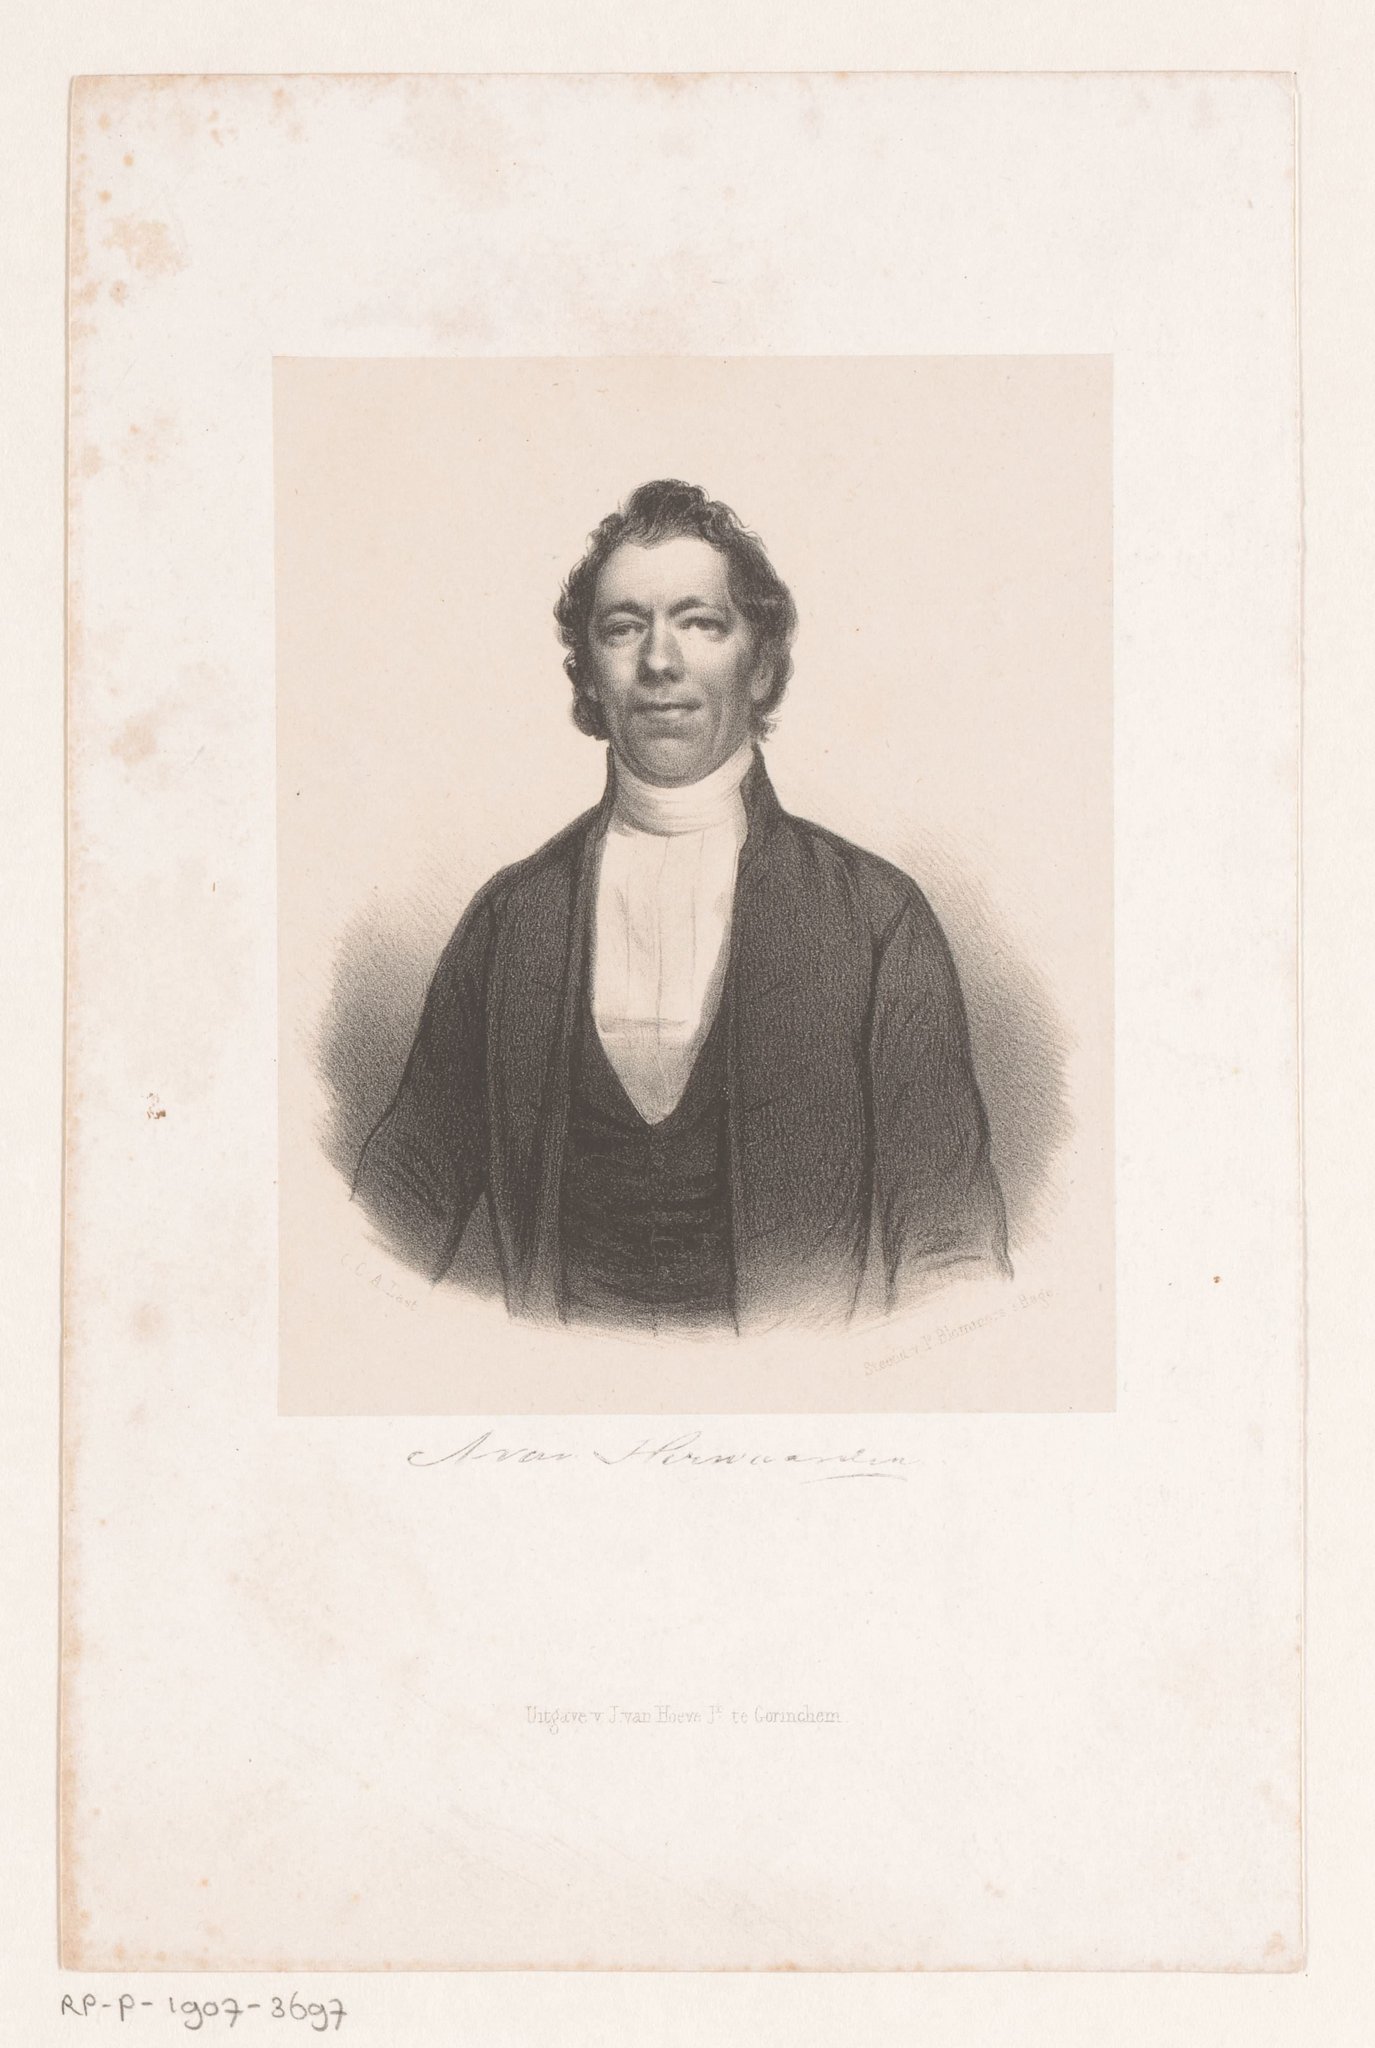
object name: print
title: Portret van Adrianus van Herwaarden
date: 1842-1887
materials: paper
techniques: lithograph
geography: netherlands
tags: historical persons (+ (full) bust portrait)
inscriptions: collector's mark: Lugt 2228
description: Onder het portret de signatuur van de geportretteerde.